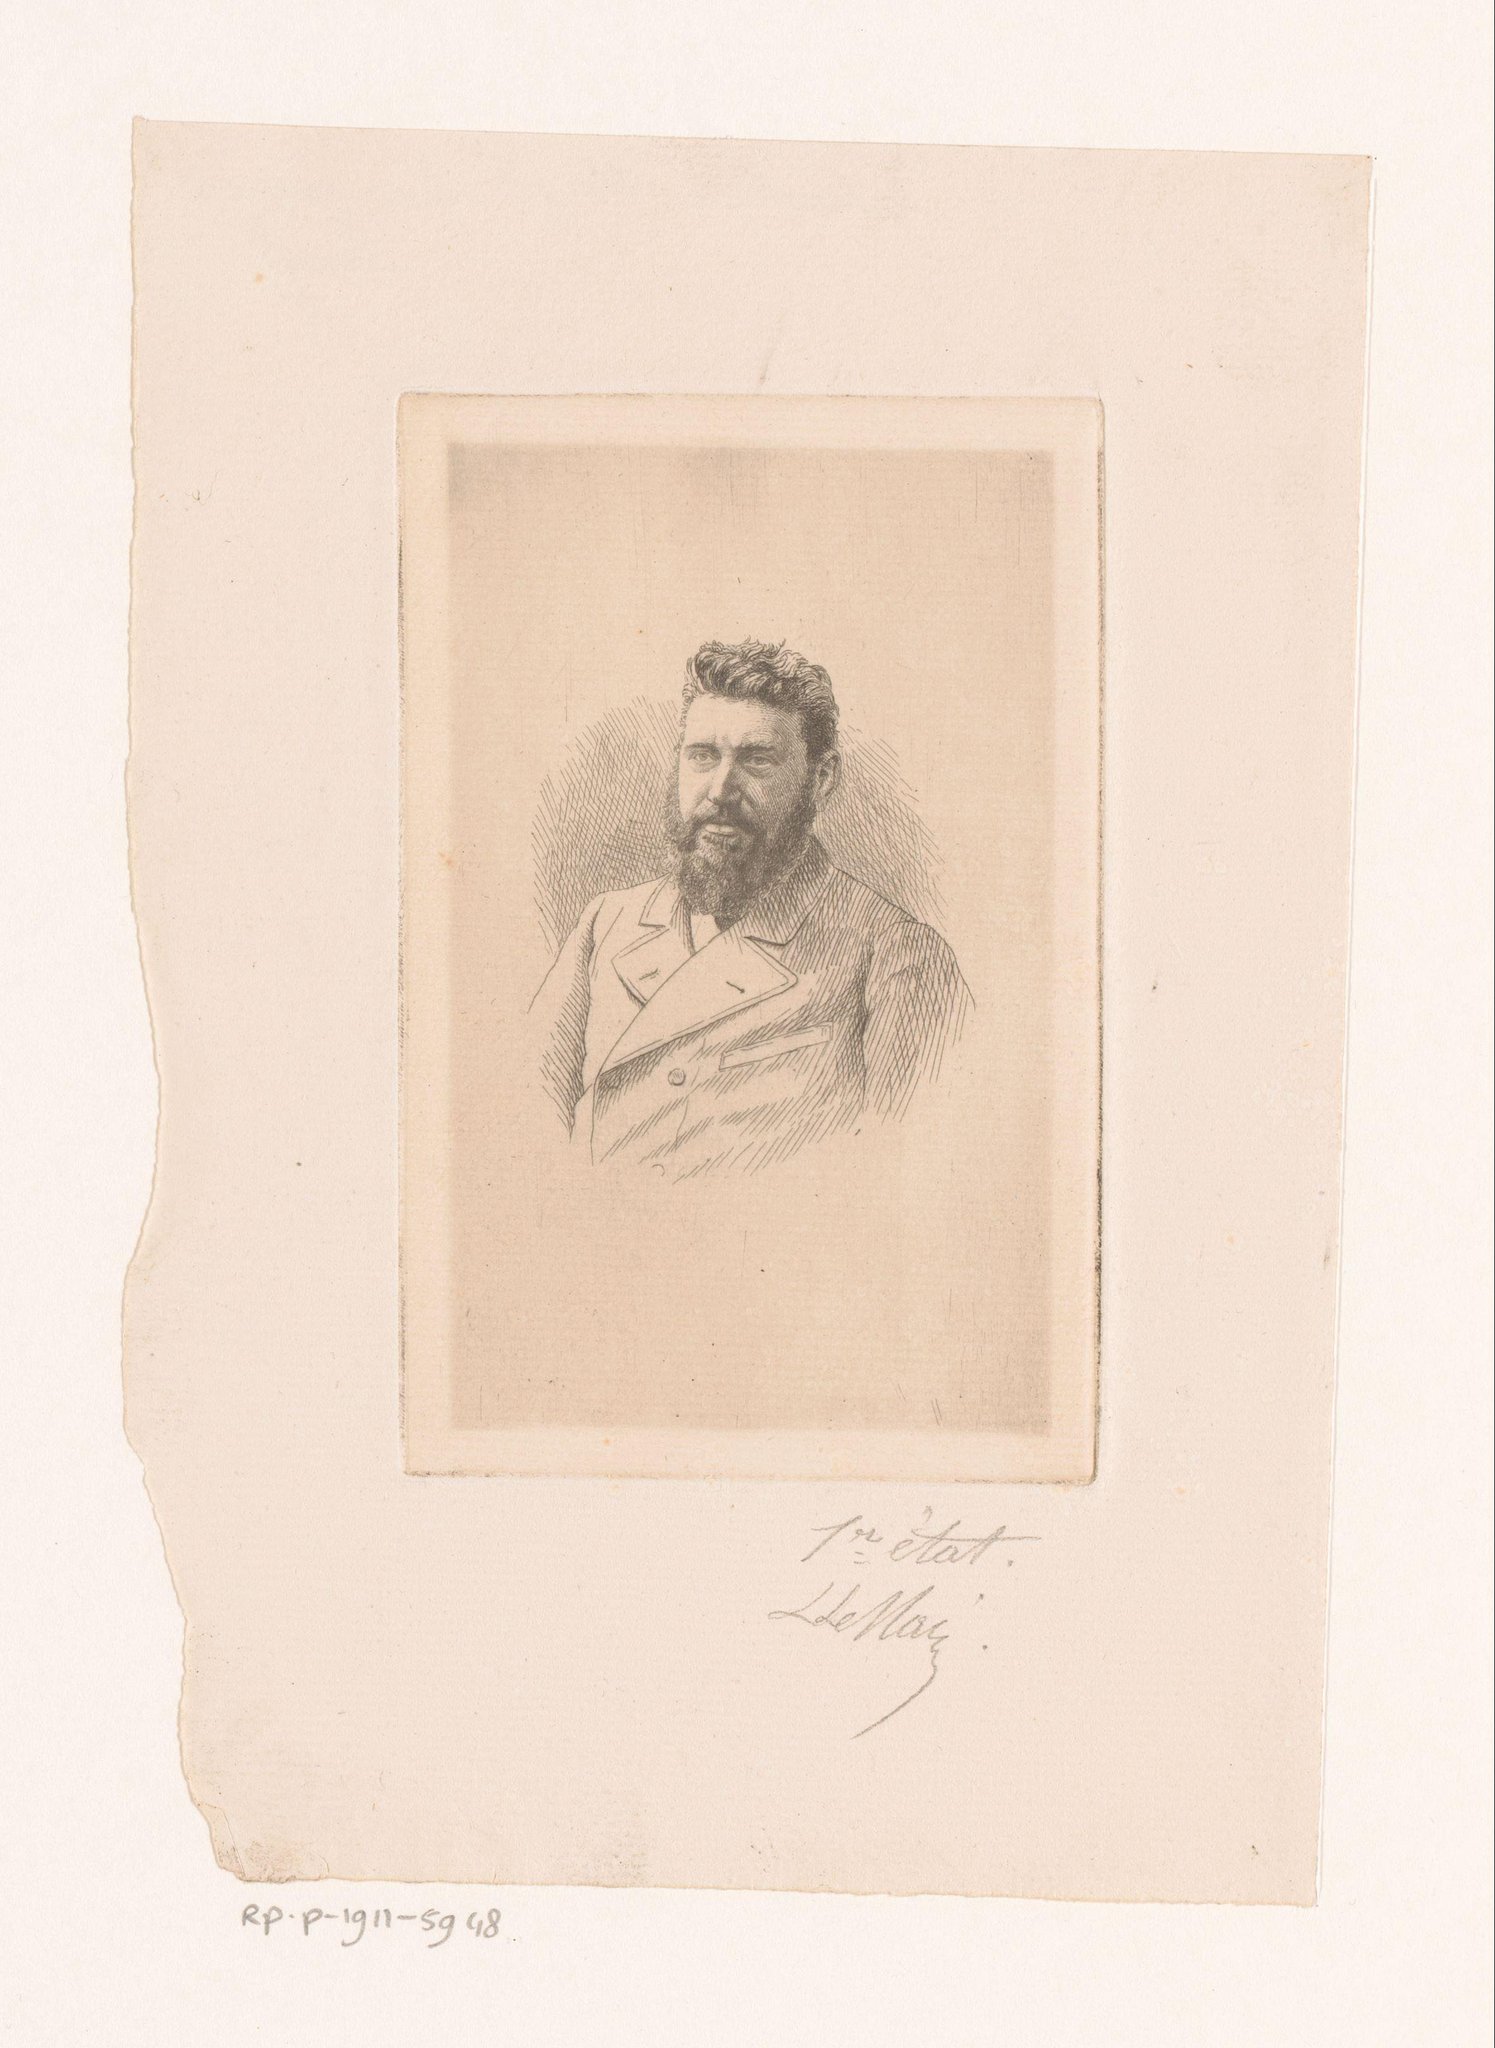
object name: print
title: Portret van een onbekende man, mogelijk Lemerre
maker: louis le nain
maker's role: print maker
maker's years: 1851-1939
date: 1861-1911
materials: paper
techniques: etching, intaglio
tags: adult man, historical persons, beard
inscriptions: collector's mark: Lugt 2228, inscription: ‘1e état LLe Nain’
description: In inventaris onder de naam 'Mr. Lemerre'.